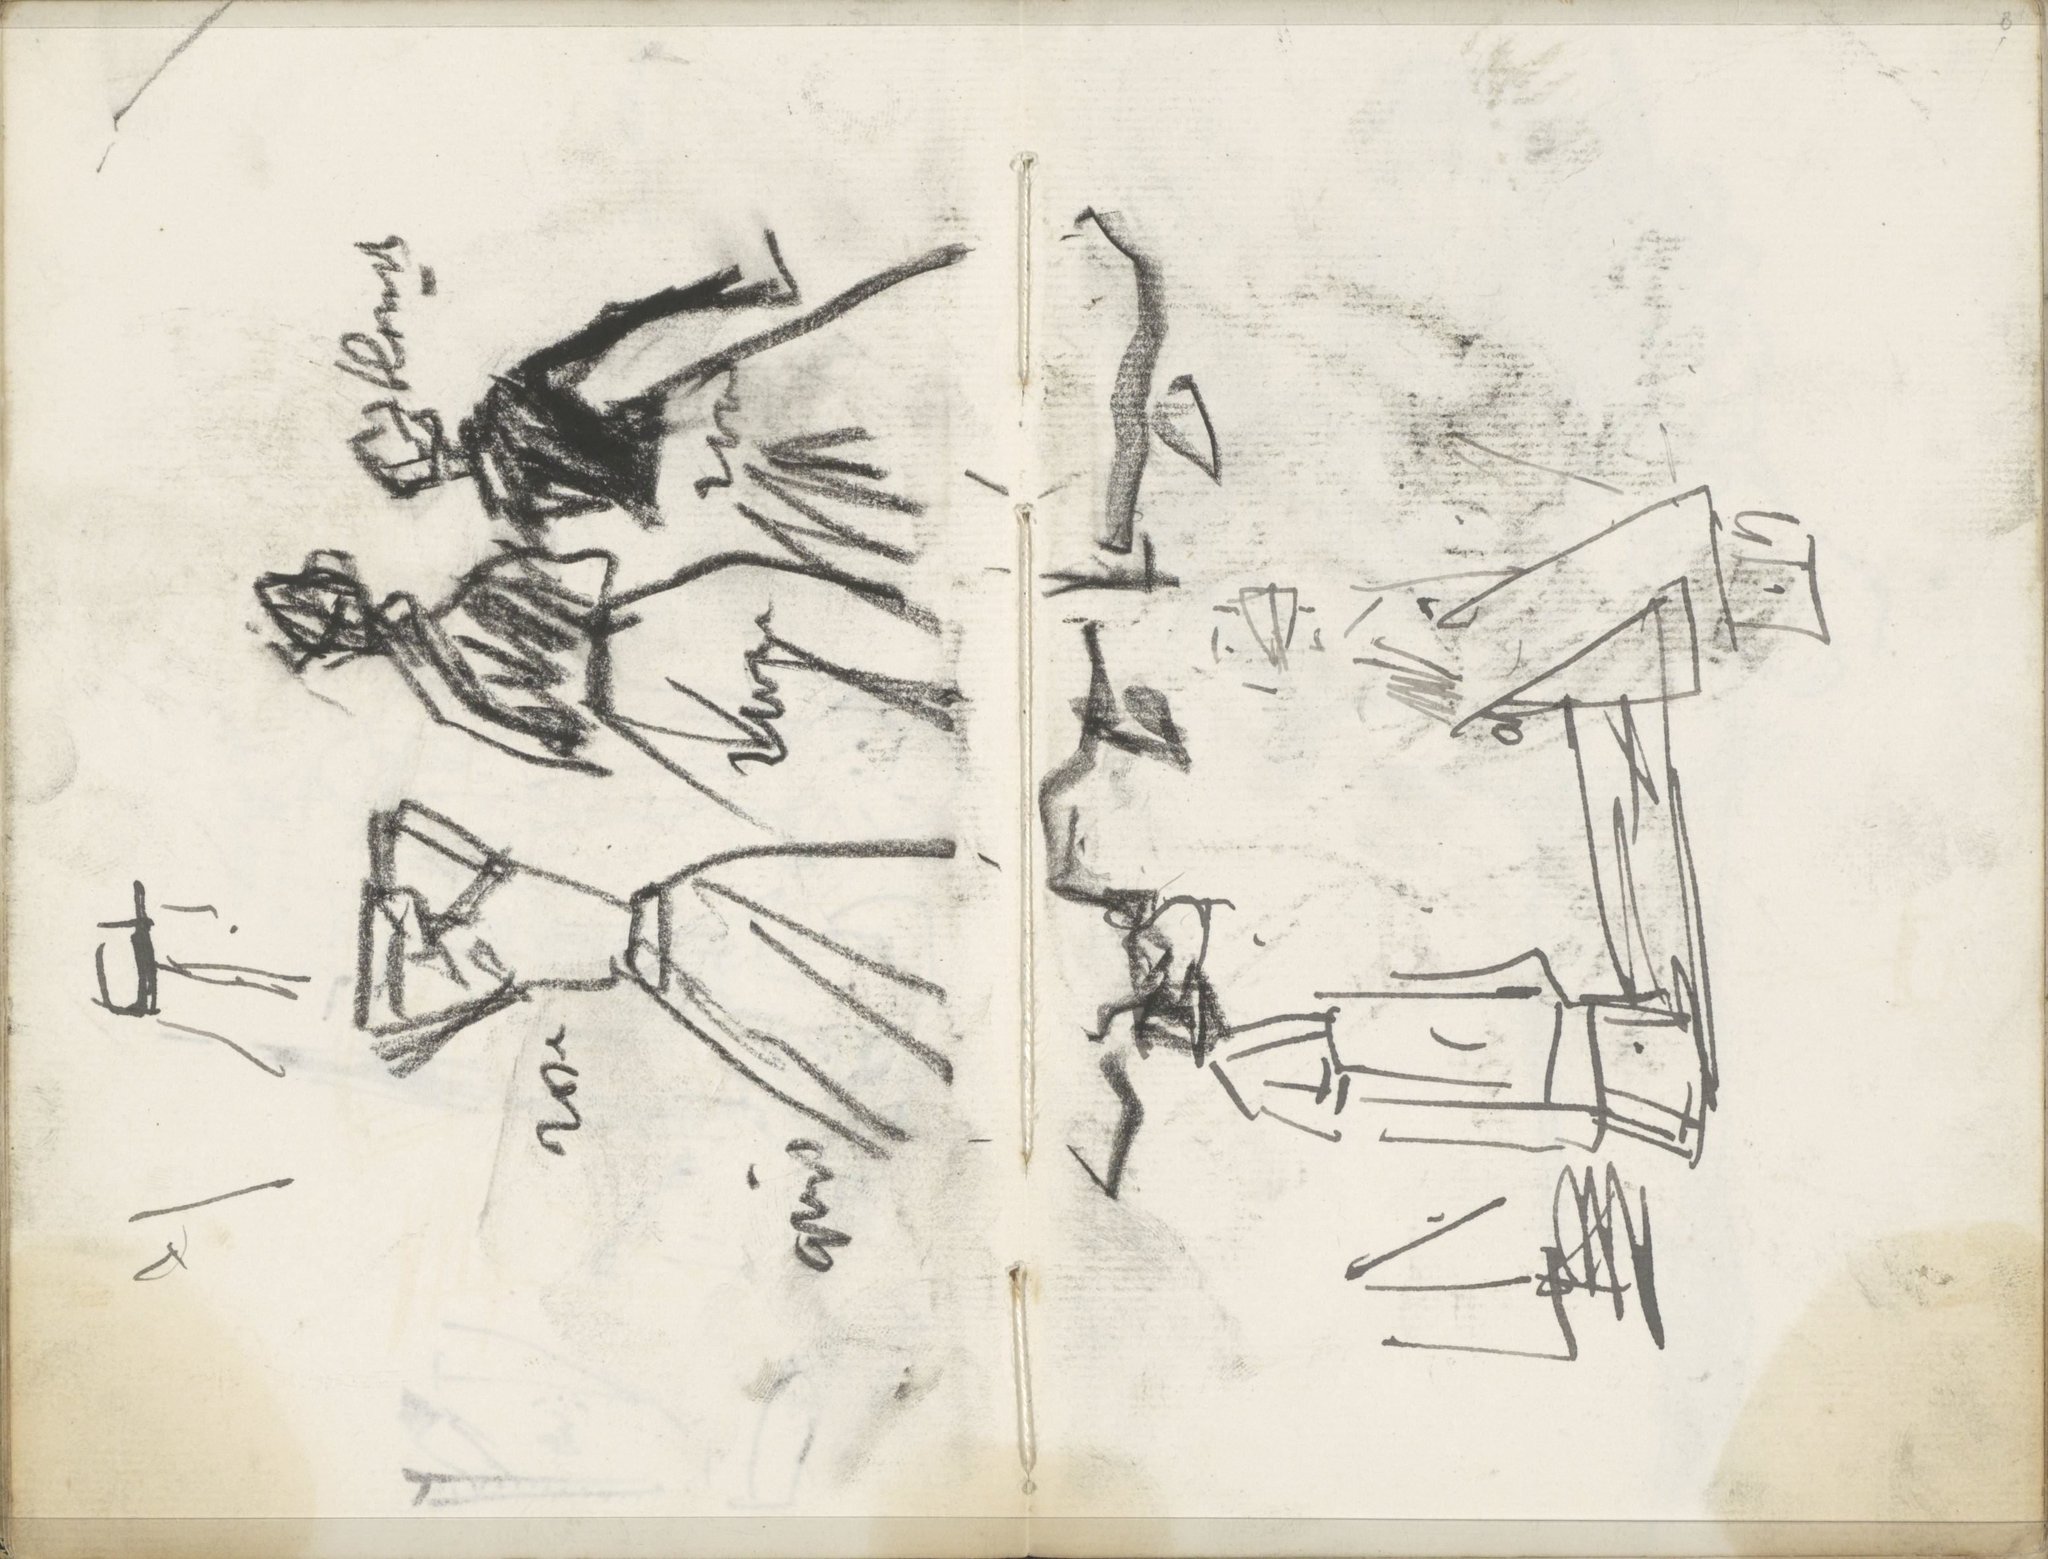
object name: sketchbook leaf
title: Vrouwen, op de rug gezien en in profiel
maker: george hendrik breitner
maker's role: draughtsman, painter, print maker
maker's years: 1857-1923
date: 1895-1898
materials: chalk, ink, paper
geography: amsterdam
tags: adolescent, young woman, maiden (+ positions (of the human figure)), adult woman (+ positions (of the human figure)), head-gear: hat (+ women's clothes)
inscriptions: kleurnotitie, handgeschreven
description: Pagina 7 en pagina 8 uit een schetsboek met 21 bladen.